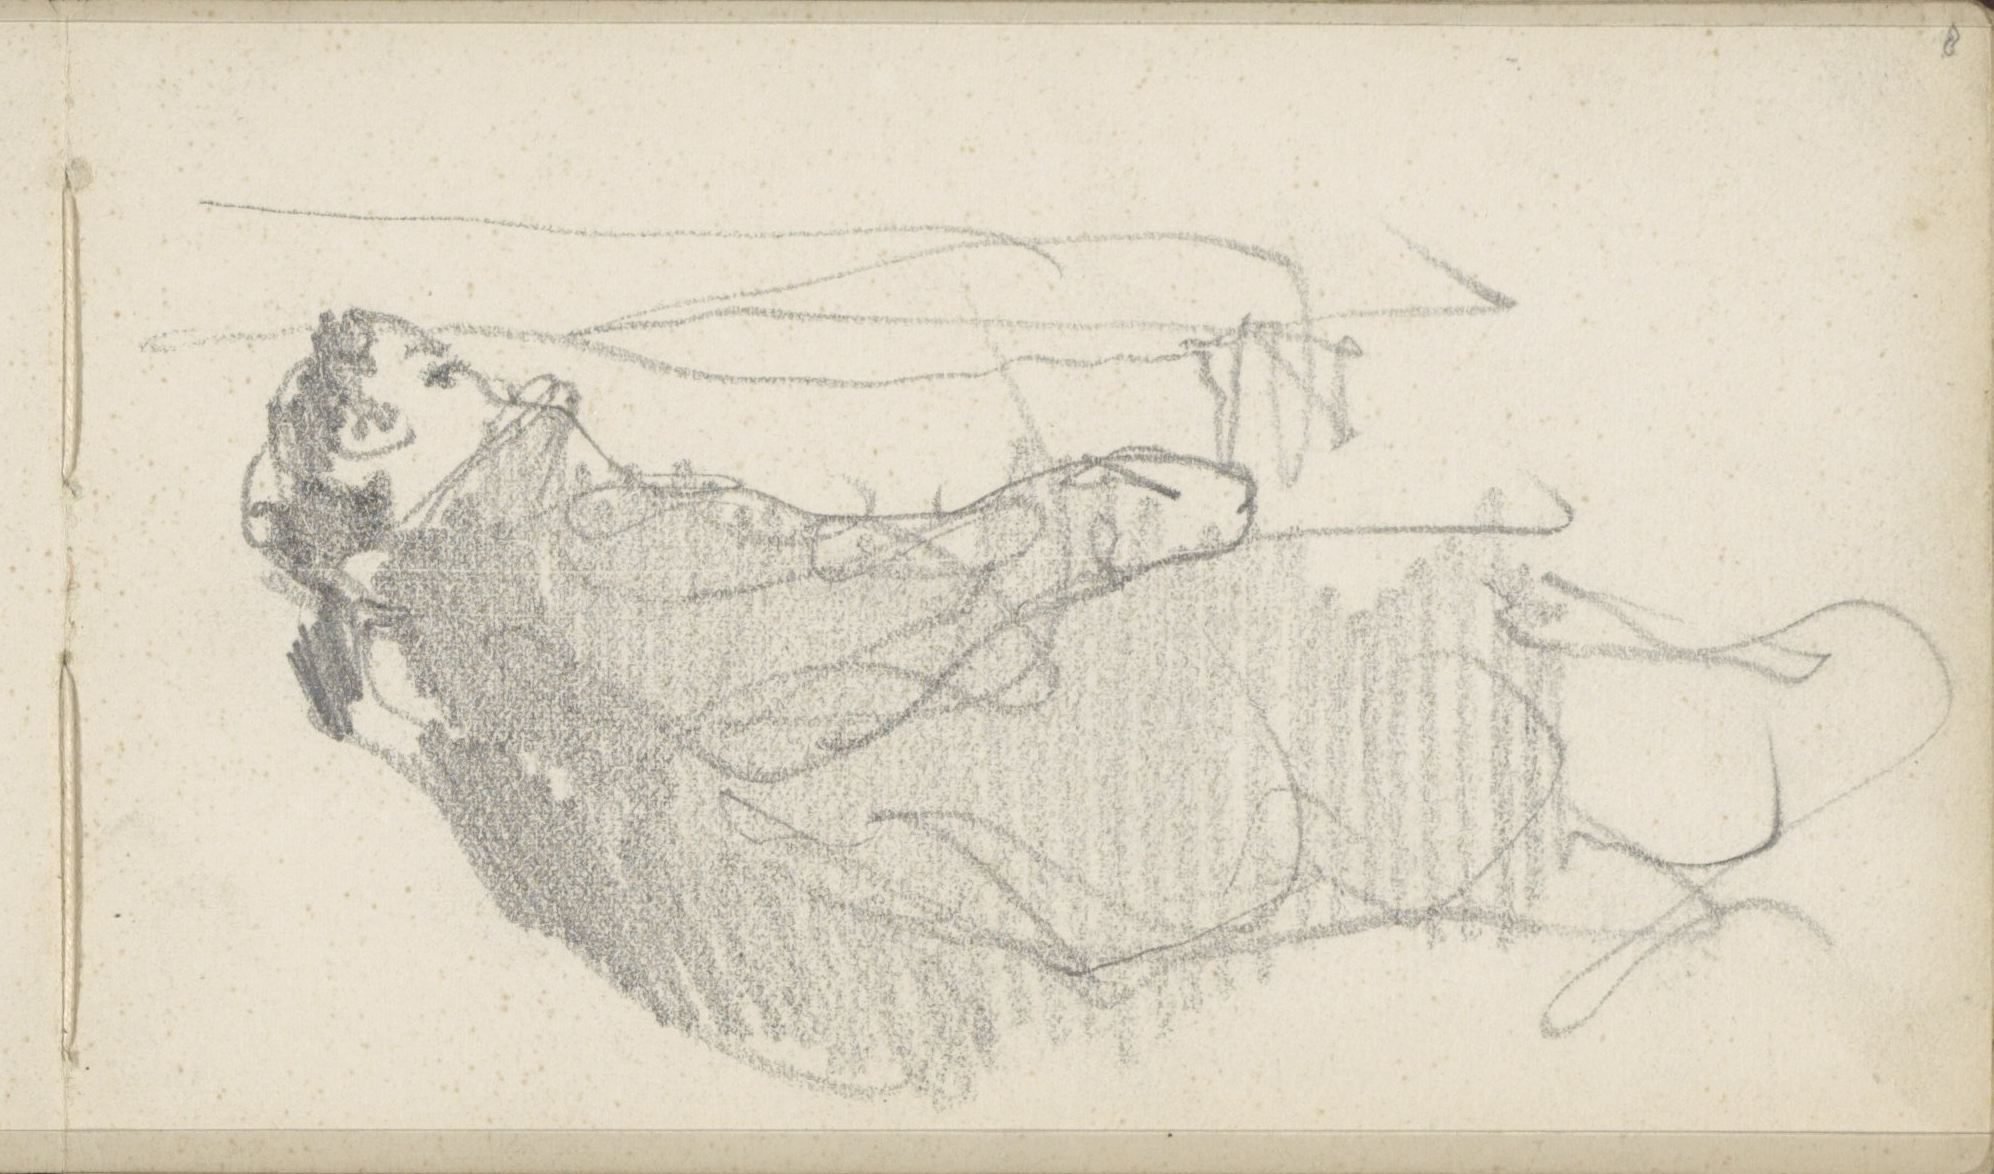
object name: sketchbook leaf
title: Figuurstudie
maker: george hendrik breitner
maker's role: draughtsman, painter, print maker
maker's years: 1857-1923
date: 1881-1883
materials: paper, pencil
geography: the hague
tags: adult man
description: Mogelijk mannen in mantels. Pagina 8 uit een schetsboek met 30 bladen.